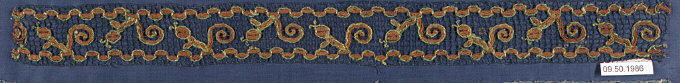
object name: strip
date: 1801-1900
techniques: embroidery